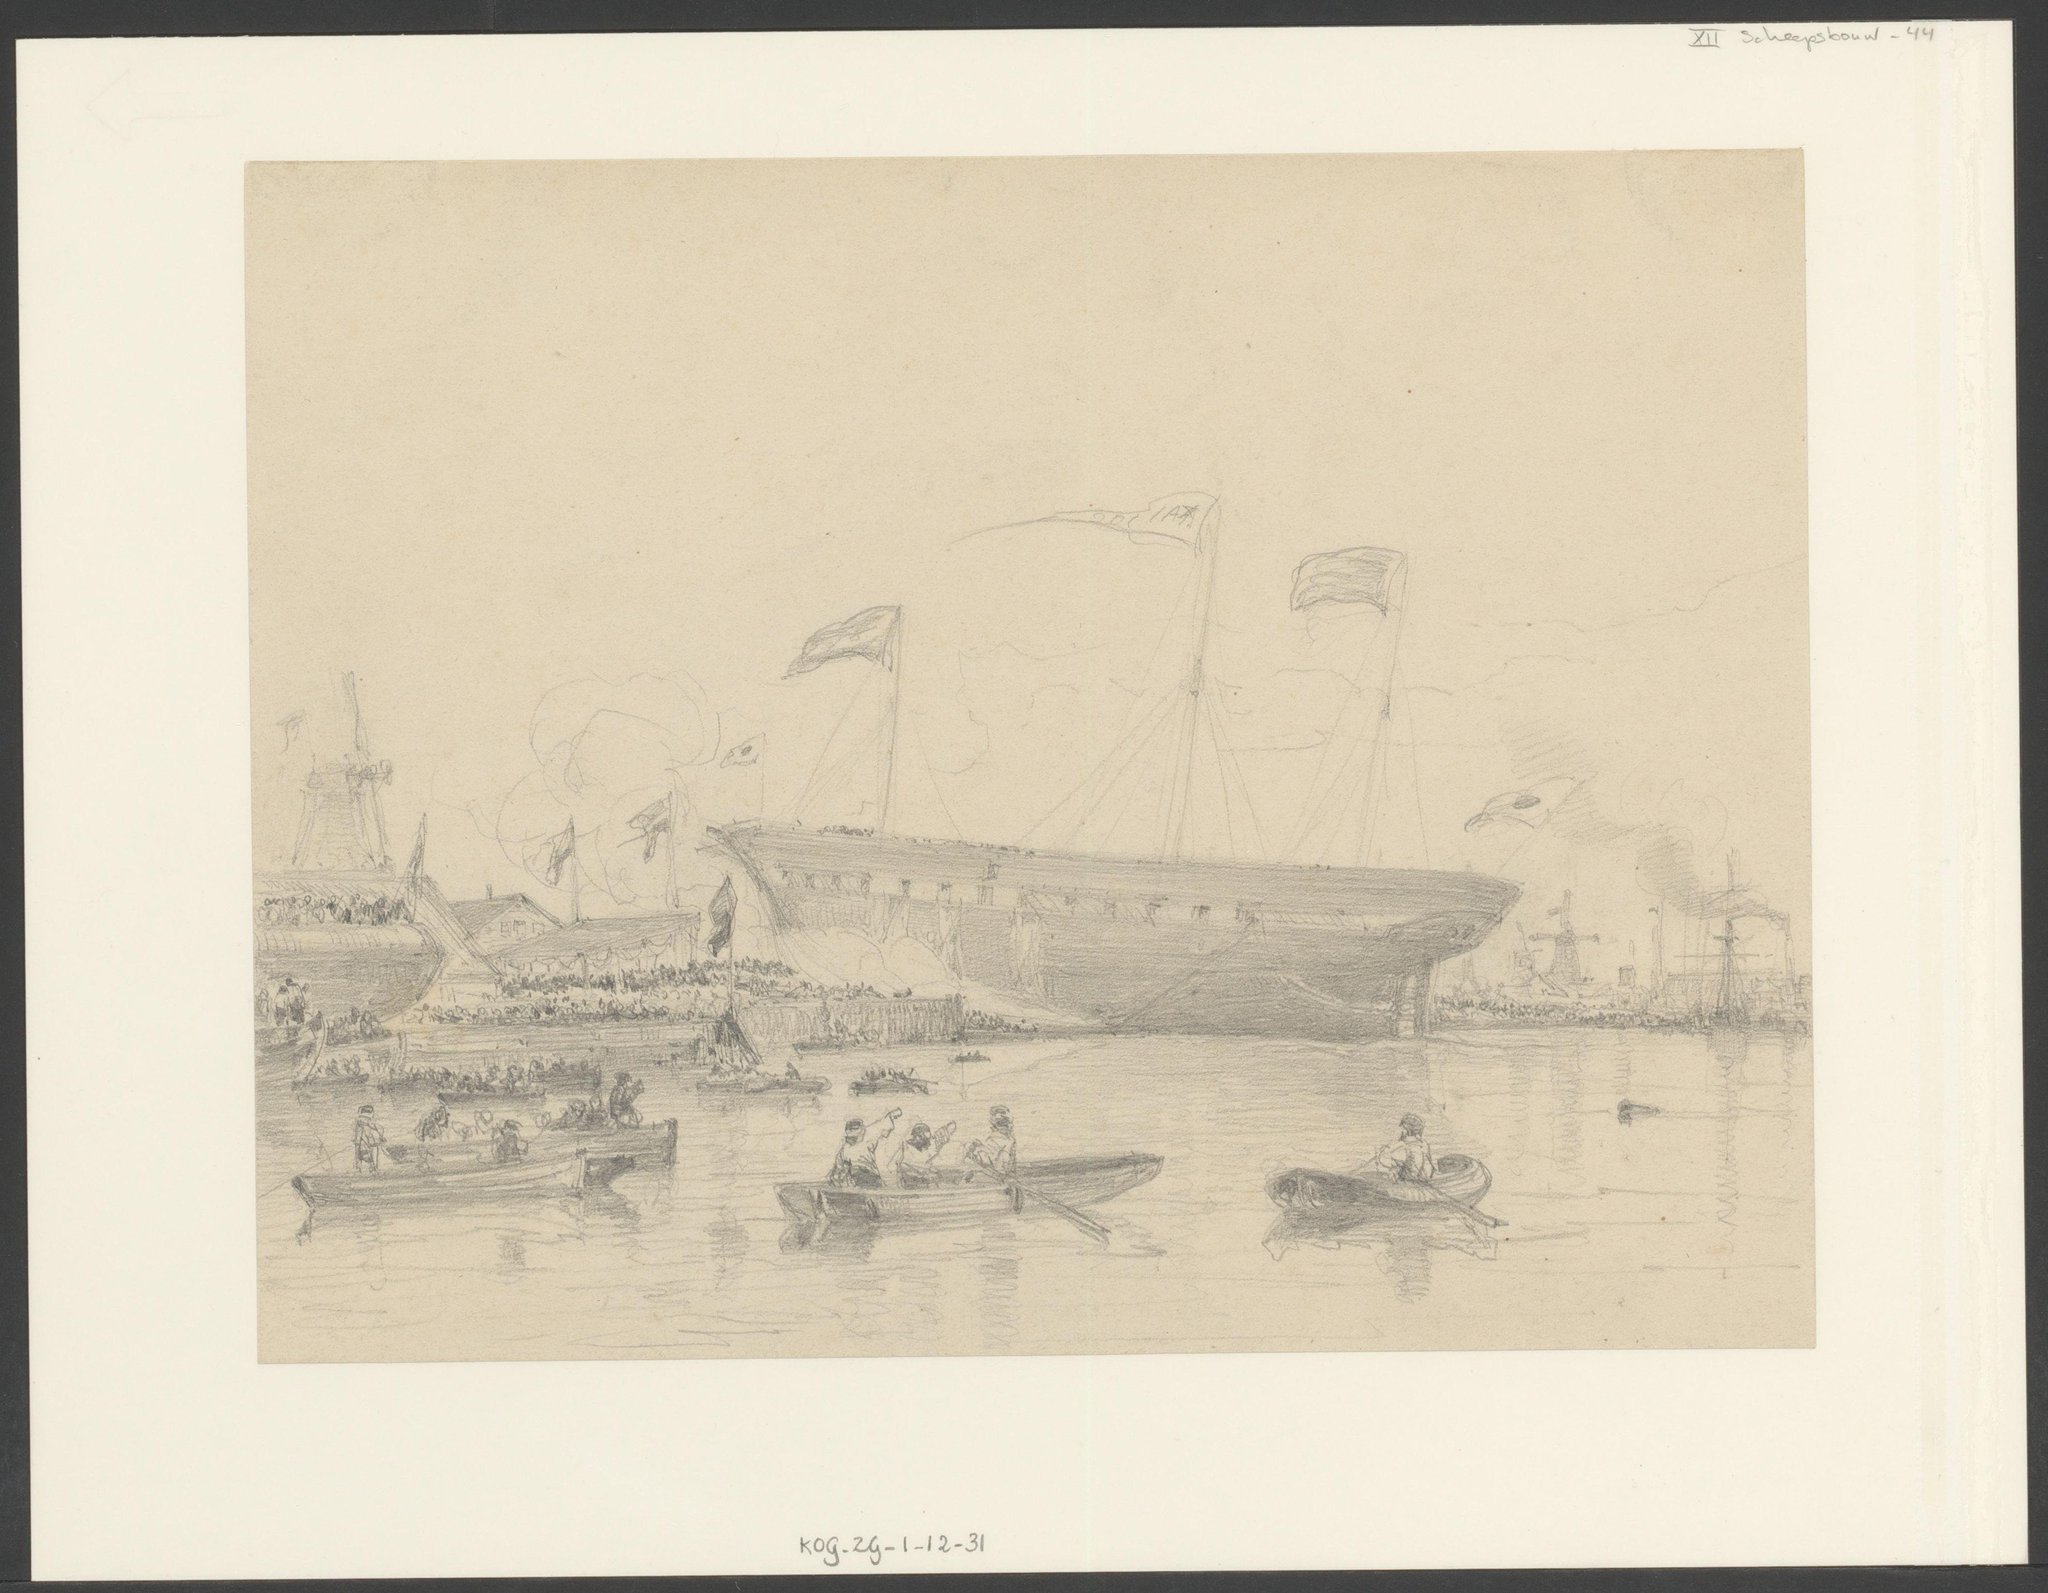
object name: drawing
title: Te water laten van de Kai-yoo-mar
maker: johan conrad greive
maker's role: draughtsman, painter, print maker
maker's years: 1837-1891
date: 1865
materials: paper, pencil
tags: ships (in general), harbouring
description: Het van stapel lopen op 2 november 1865 bij de scheepswerf Gips te Dordrecht van het voor de Japanse marine gebouwde oorlogsschip Kai-yoo-mar (Kaiyo Maru).